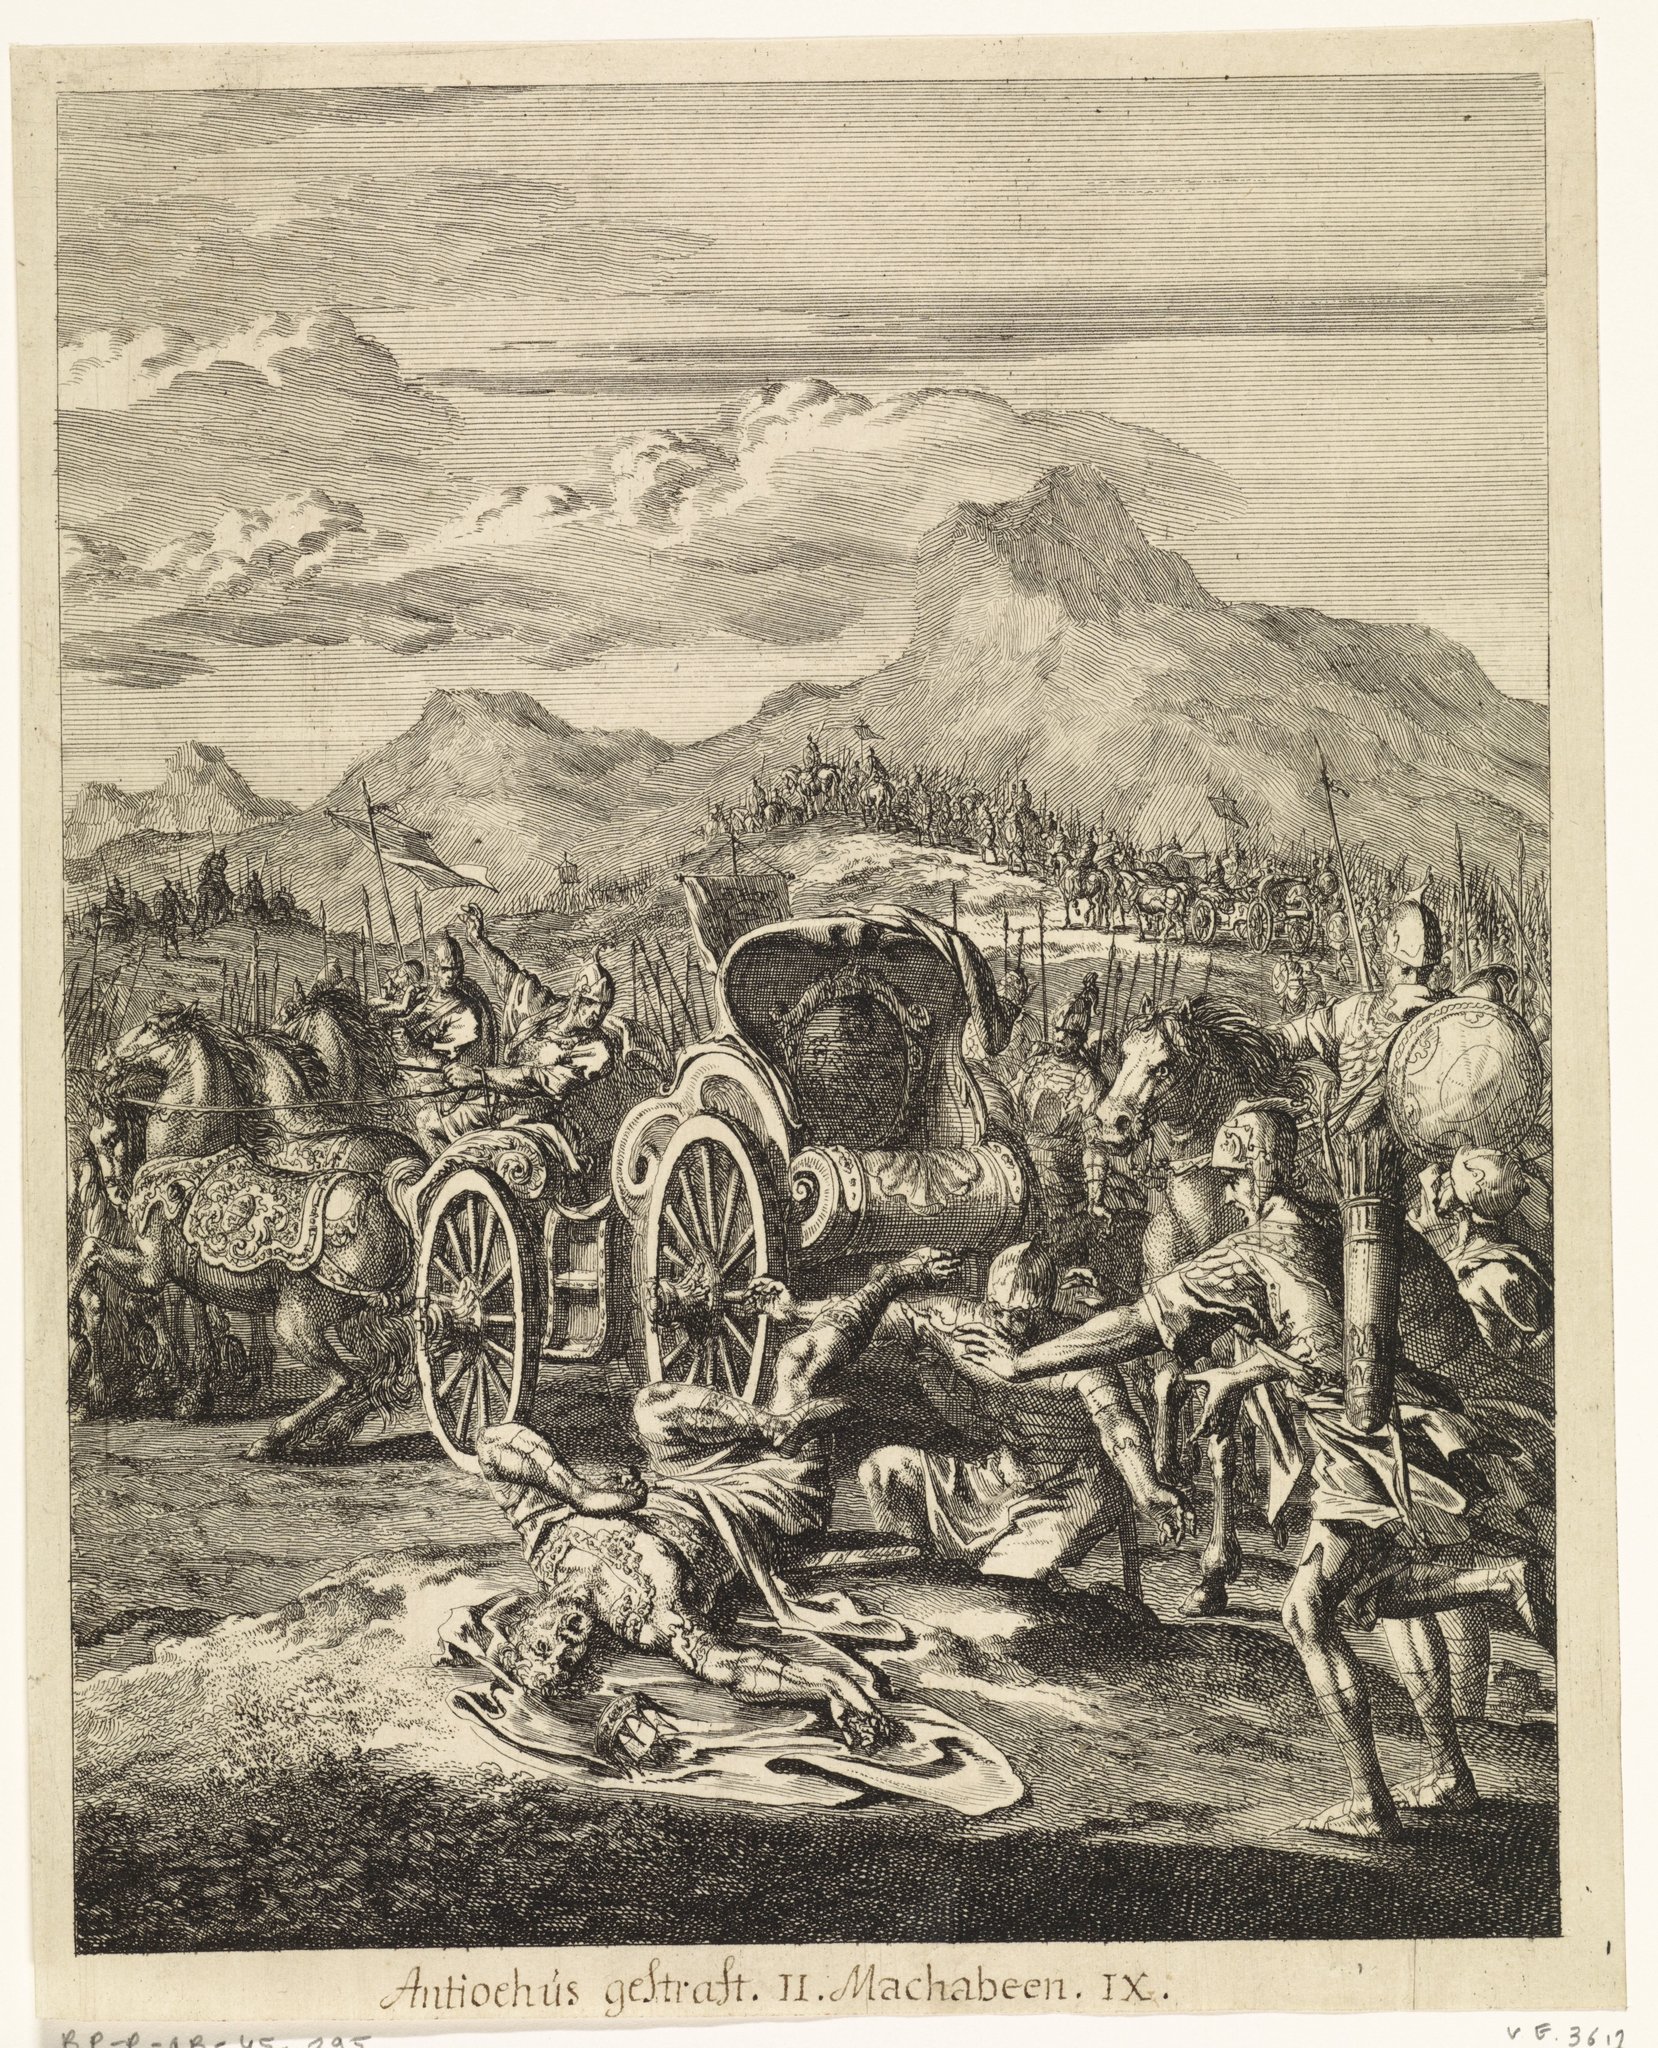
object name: print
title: Dood van Antiochus Epifanes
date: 1708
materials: paper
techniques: etching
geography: amsterdam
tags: antiochus iv epiphanes falls from his chariot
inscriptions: collector's mark: Lugt 2228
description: Proefdruk van een prent welke is opgenomen als illustratie in: Historiae Celebriores Veteris Testamenti. Christoph Weigel, 1708.